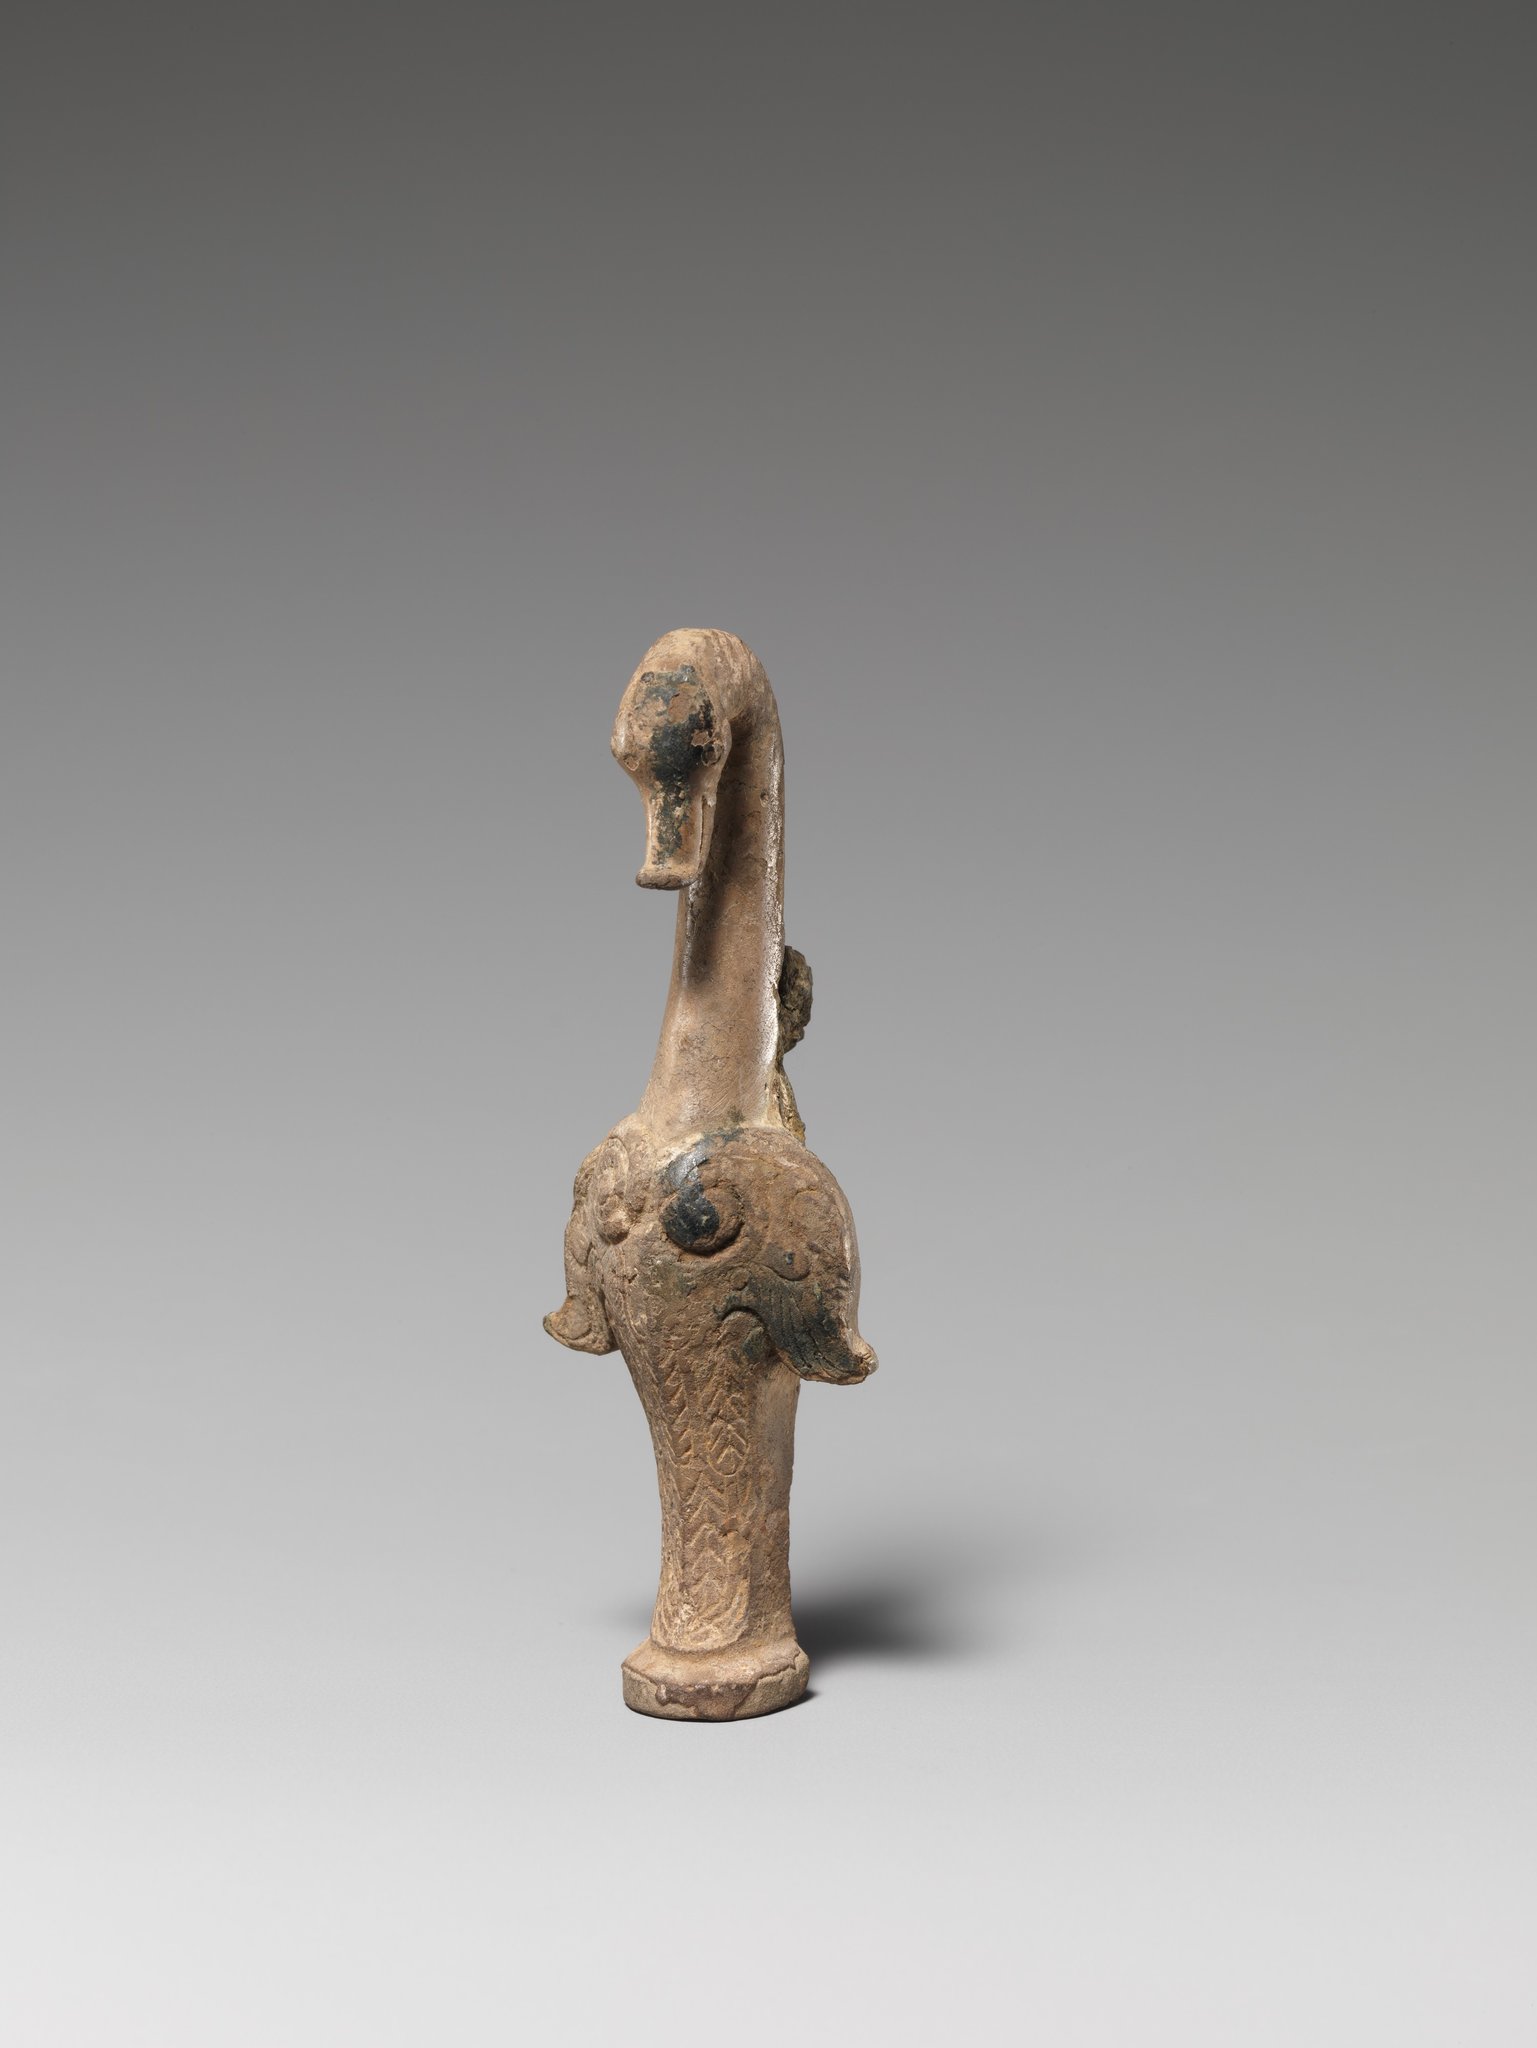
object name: vessel leg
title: Vessel leg in the form of a bird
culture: chinese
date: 500-201 BCE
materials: bronze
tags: birds